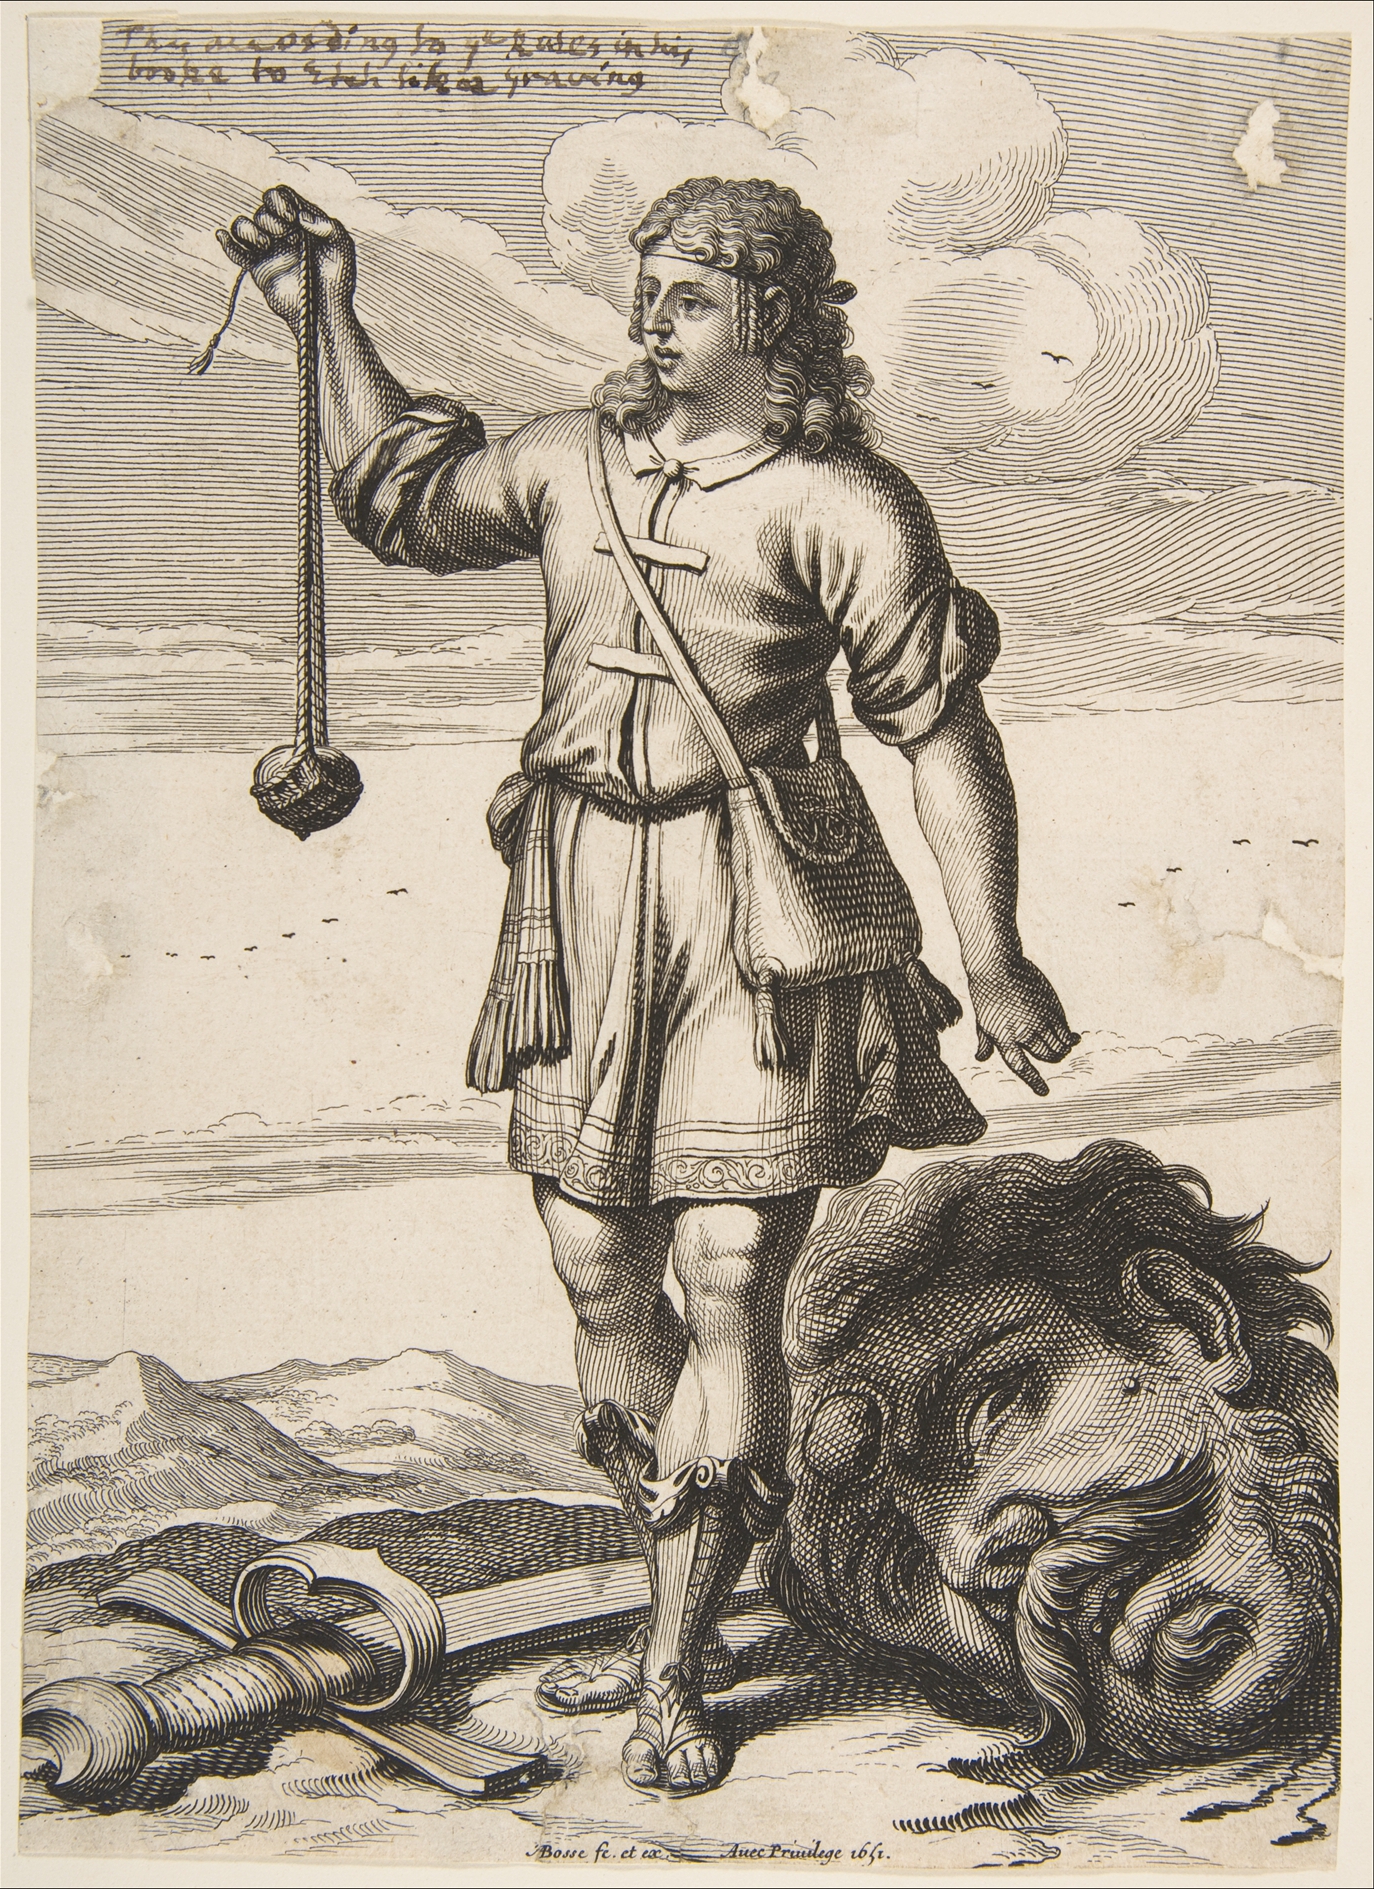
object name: print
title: David with the Head of Goliath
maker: abraham bosse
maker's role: artist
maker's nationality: french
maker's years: 1602-1676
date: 1651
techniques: etching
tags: swords,heads,men,david